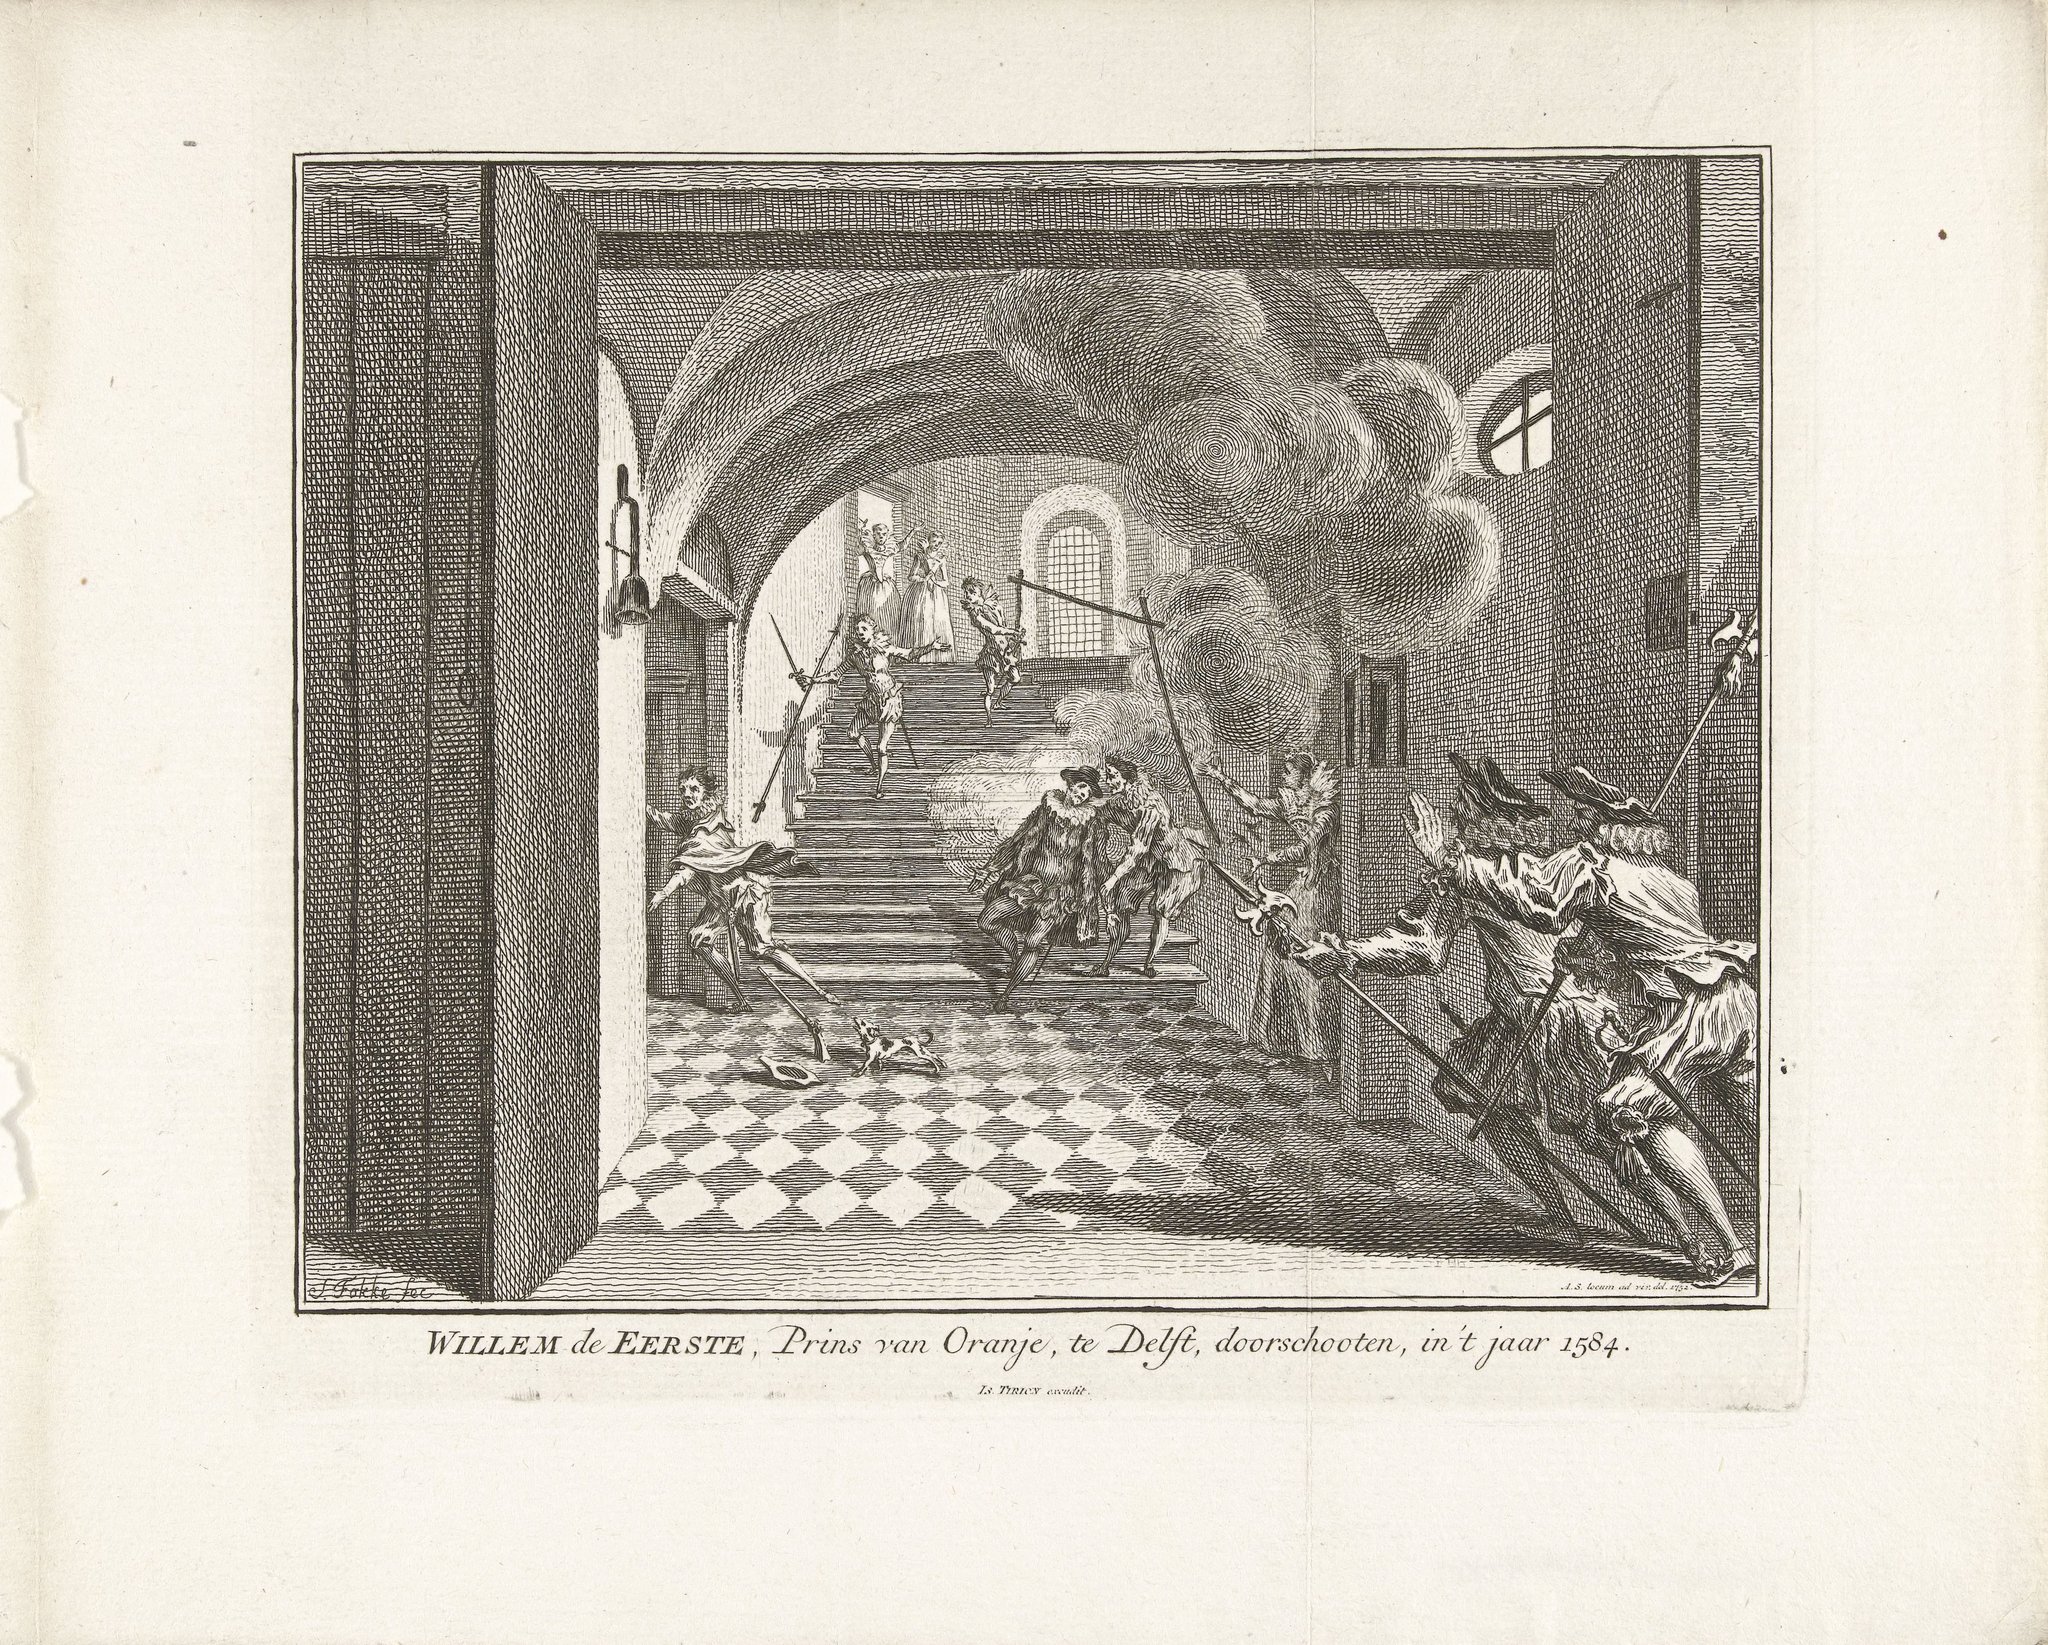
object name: print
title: Willem de Eerste, Prins van Oranje, te Delft, doorschooten, in 't jaar 1584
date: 1752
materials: paper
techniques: engraving, etching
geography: amsterdam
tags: william i (prince of orange), violent death ~ elements, attempt, political murder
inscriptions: collector's mark: Lugt 2228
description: De prins van Oranje te Delft vermoord door Balthasar Gerards, 10 juli 1584. Willem van Oranje is op de trap neergeschoten en zakt in elkaar, links vlucht de moordenaar. Rechts op de voorgrond twee toesnellende wachten.